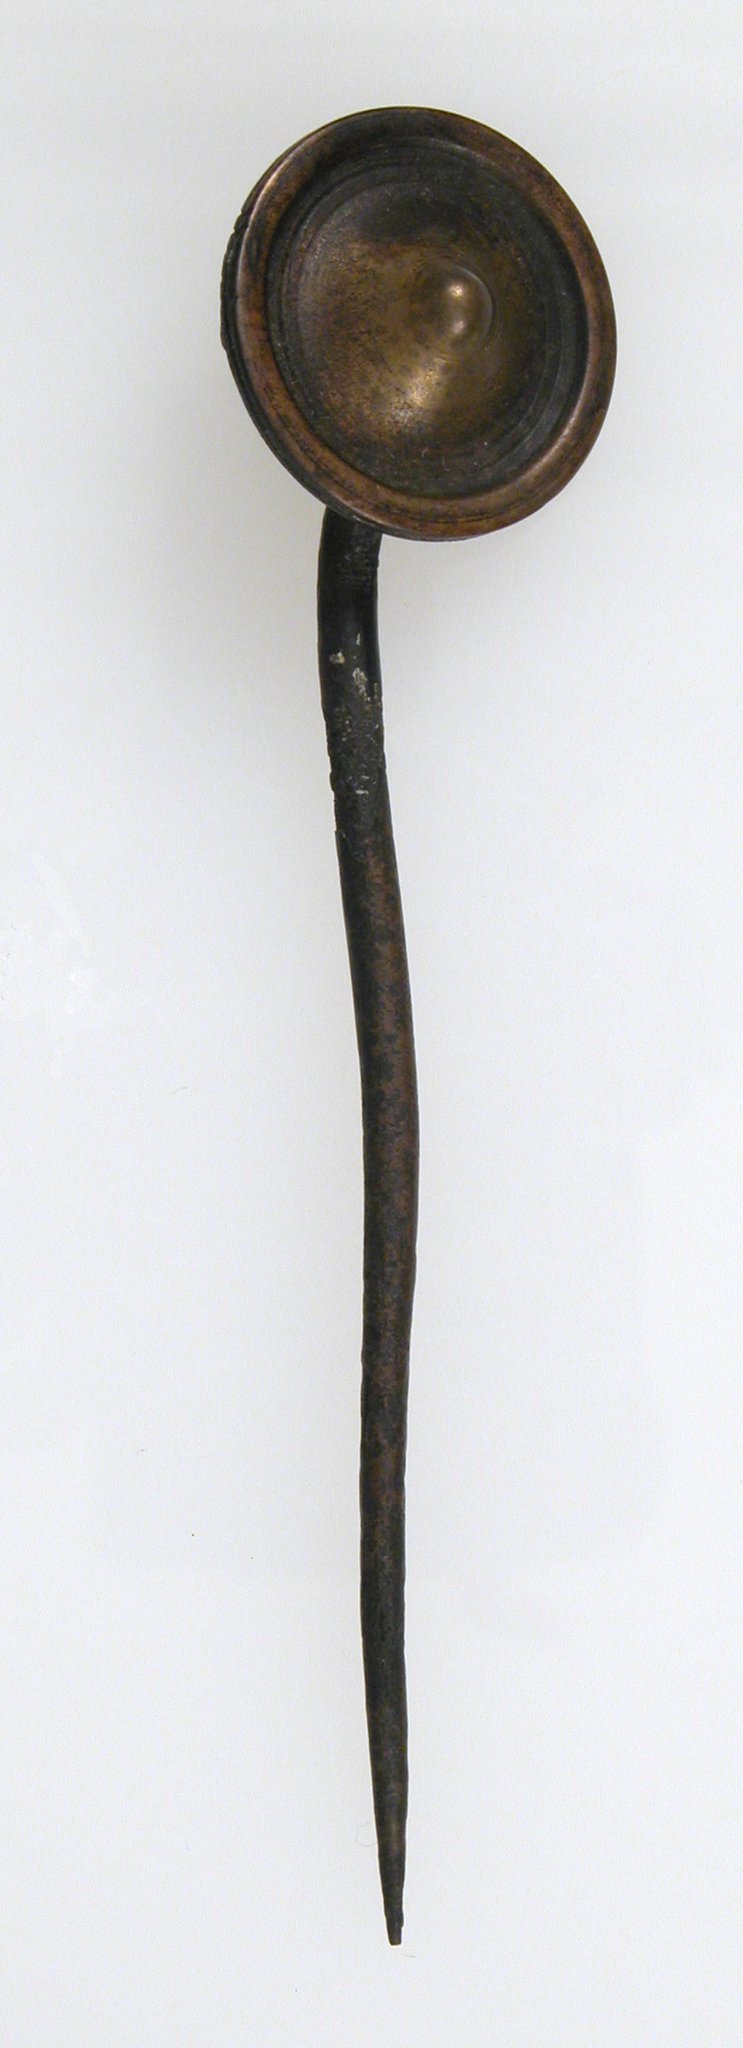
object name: pin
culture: irish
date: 801-900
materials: copper alloy